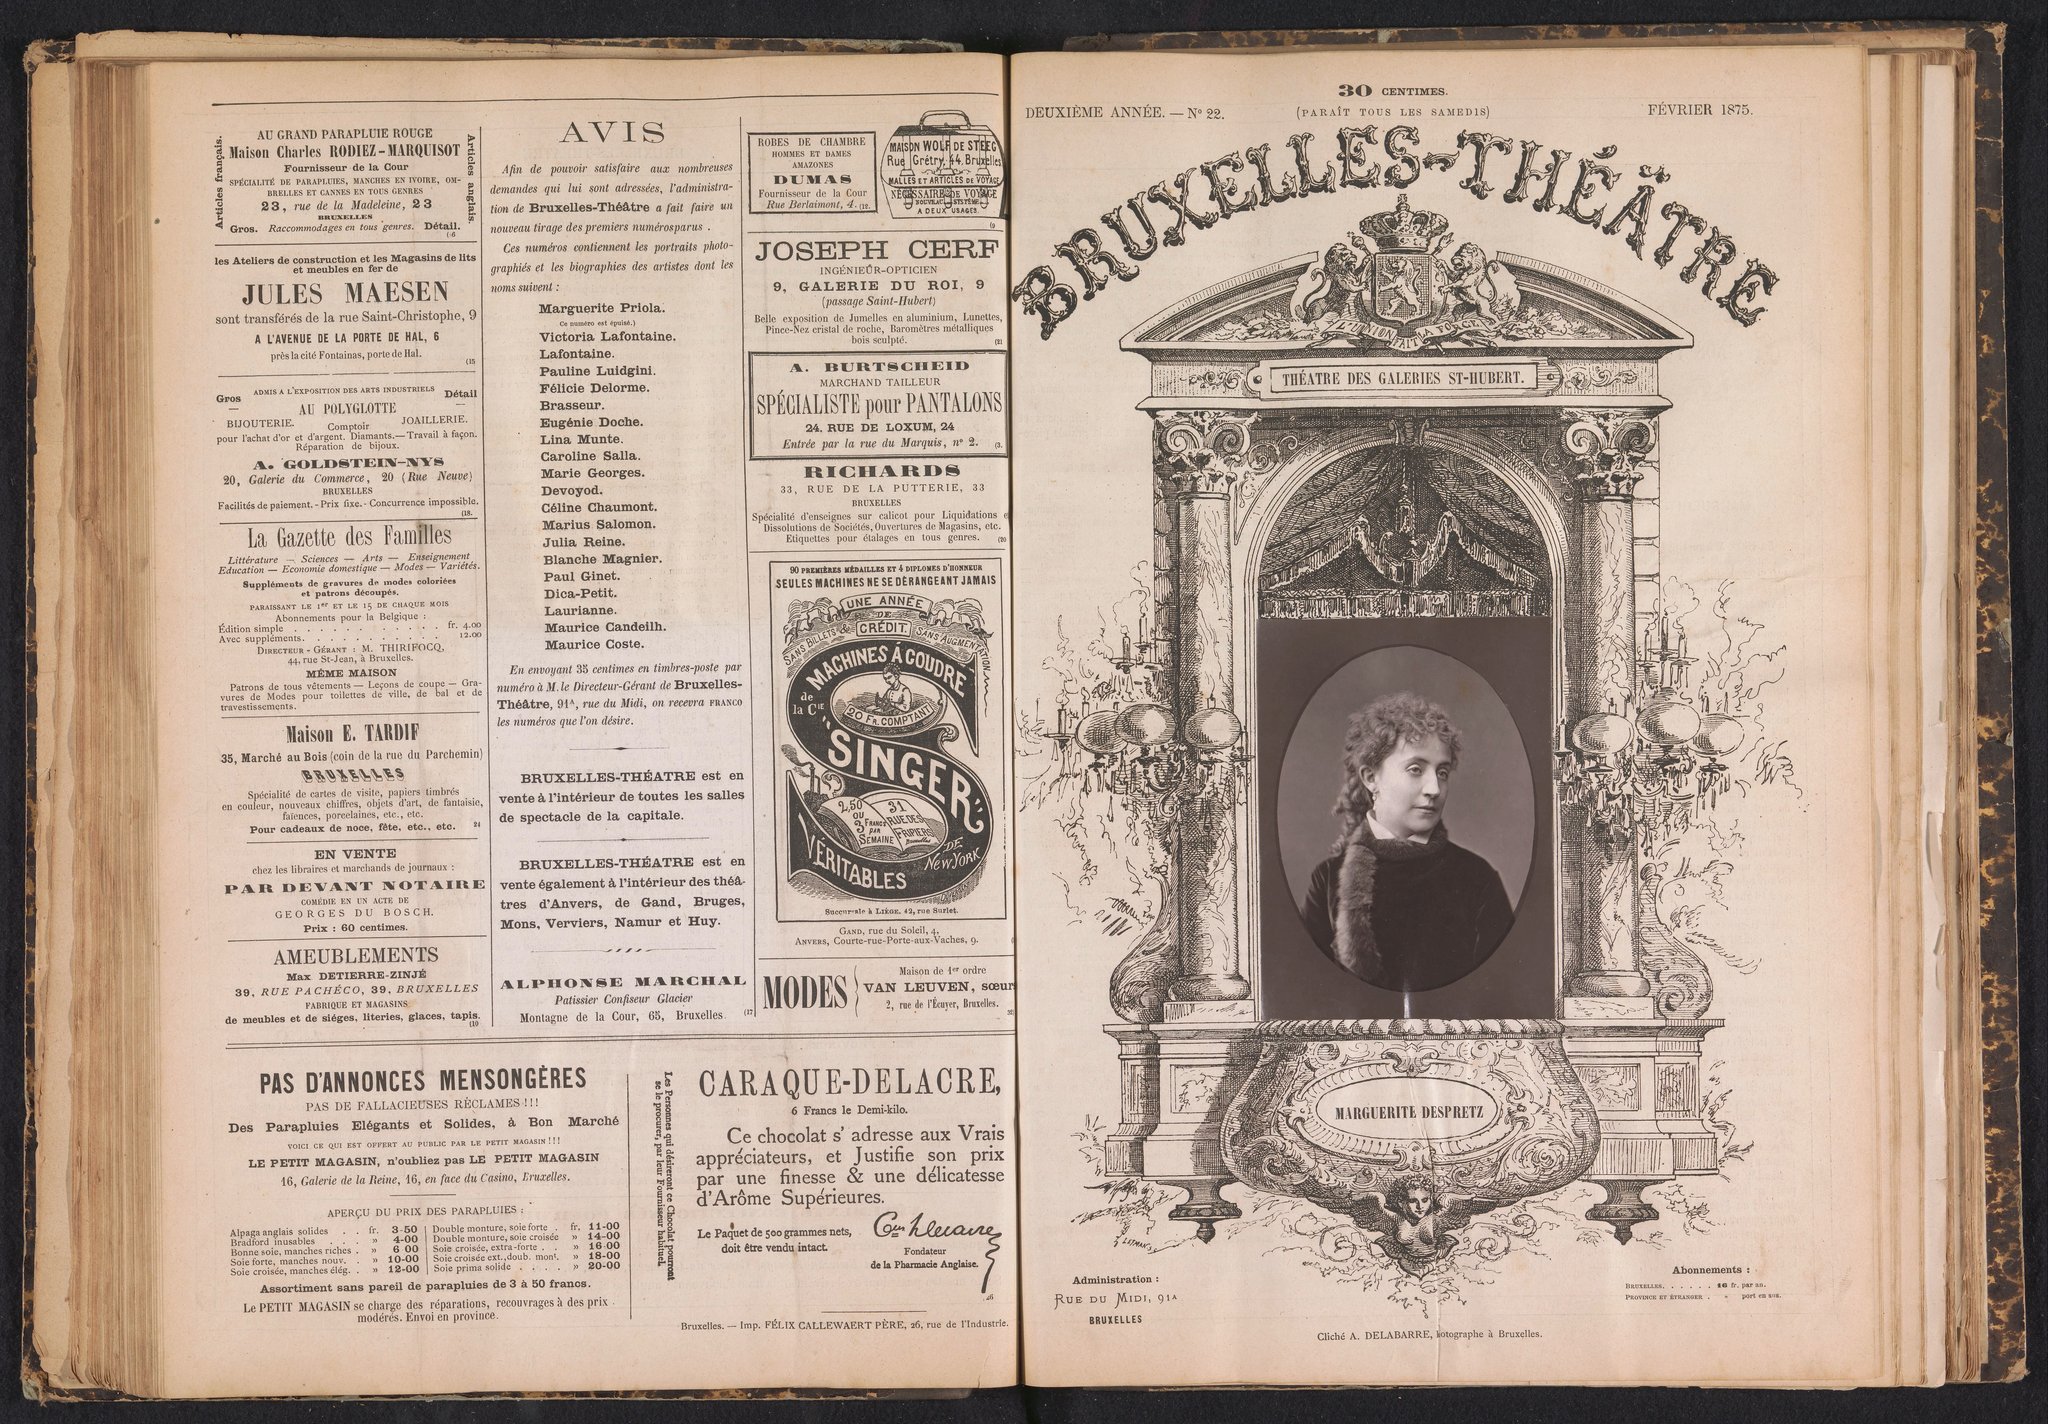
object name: photomechanical print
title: Portret van Marguerite Despretz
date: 1870-1875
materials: paper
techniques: woodburytype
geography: brussels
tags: portrait of actor, actress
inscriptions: number: ‘No 22.’